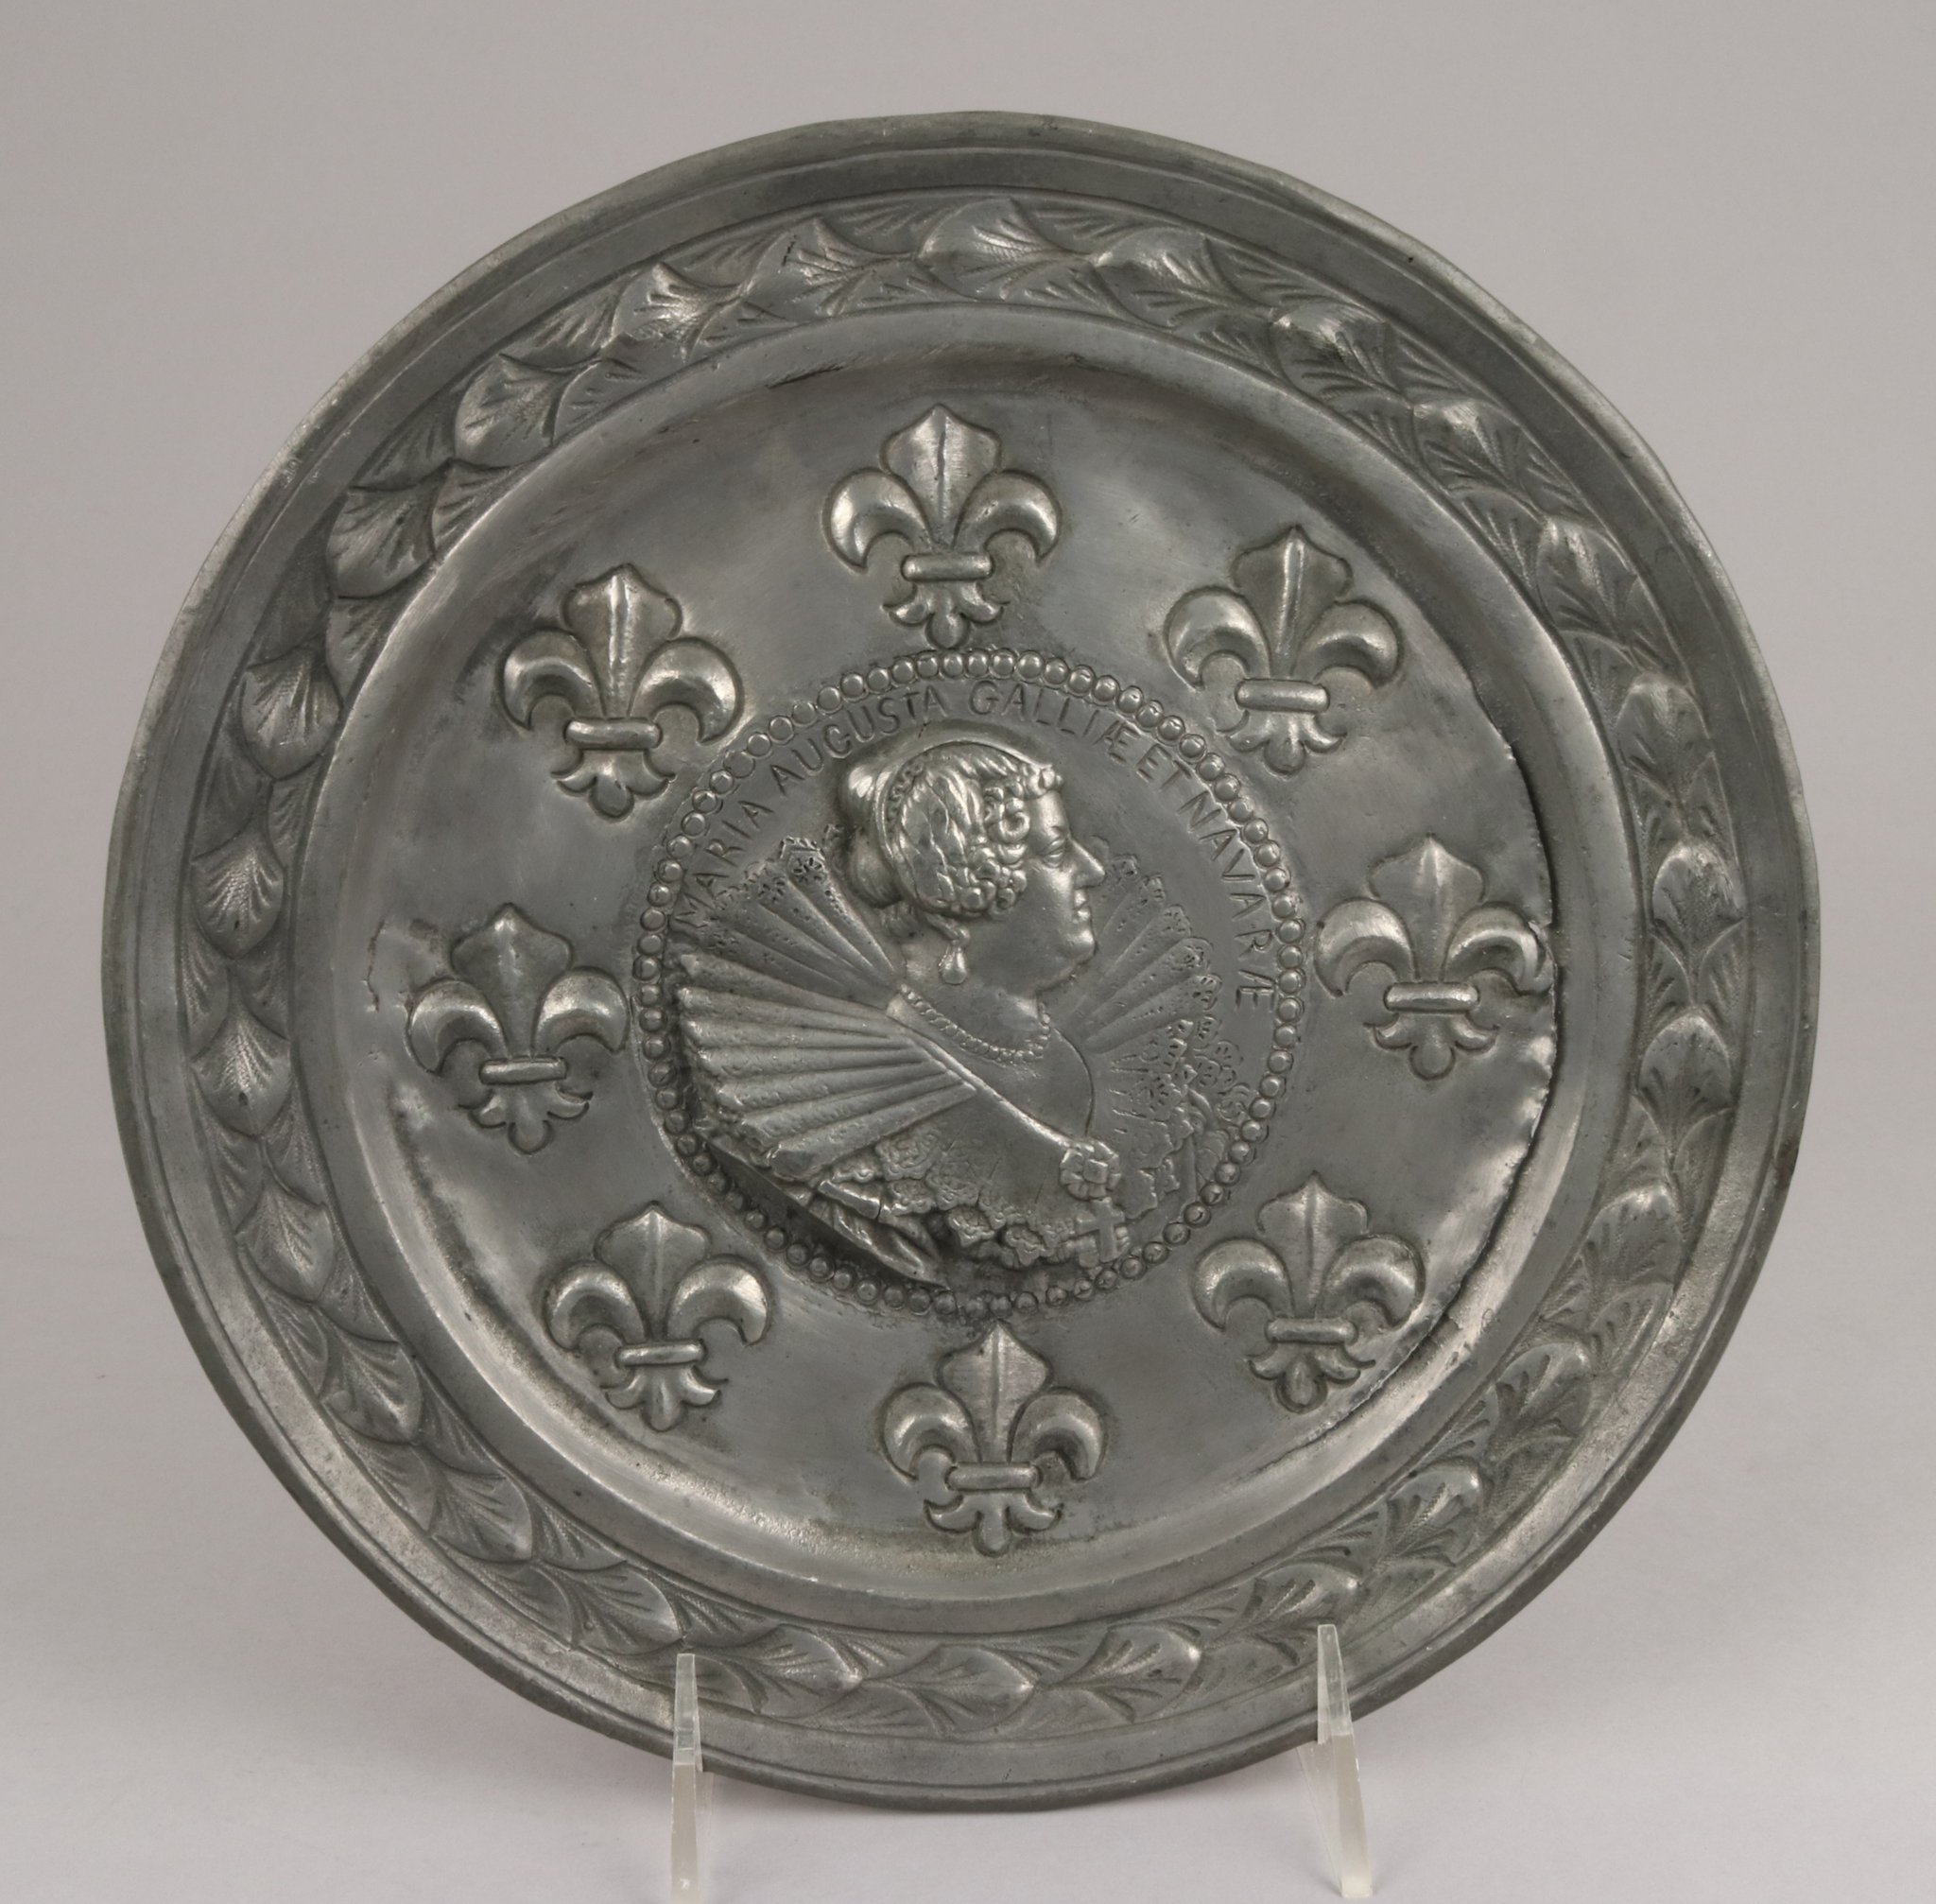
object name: plate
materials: pewter